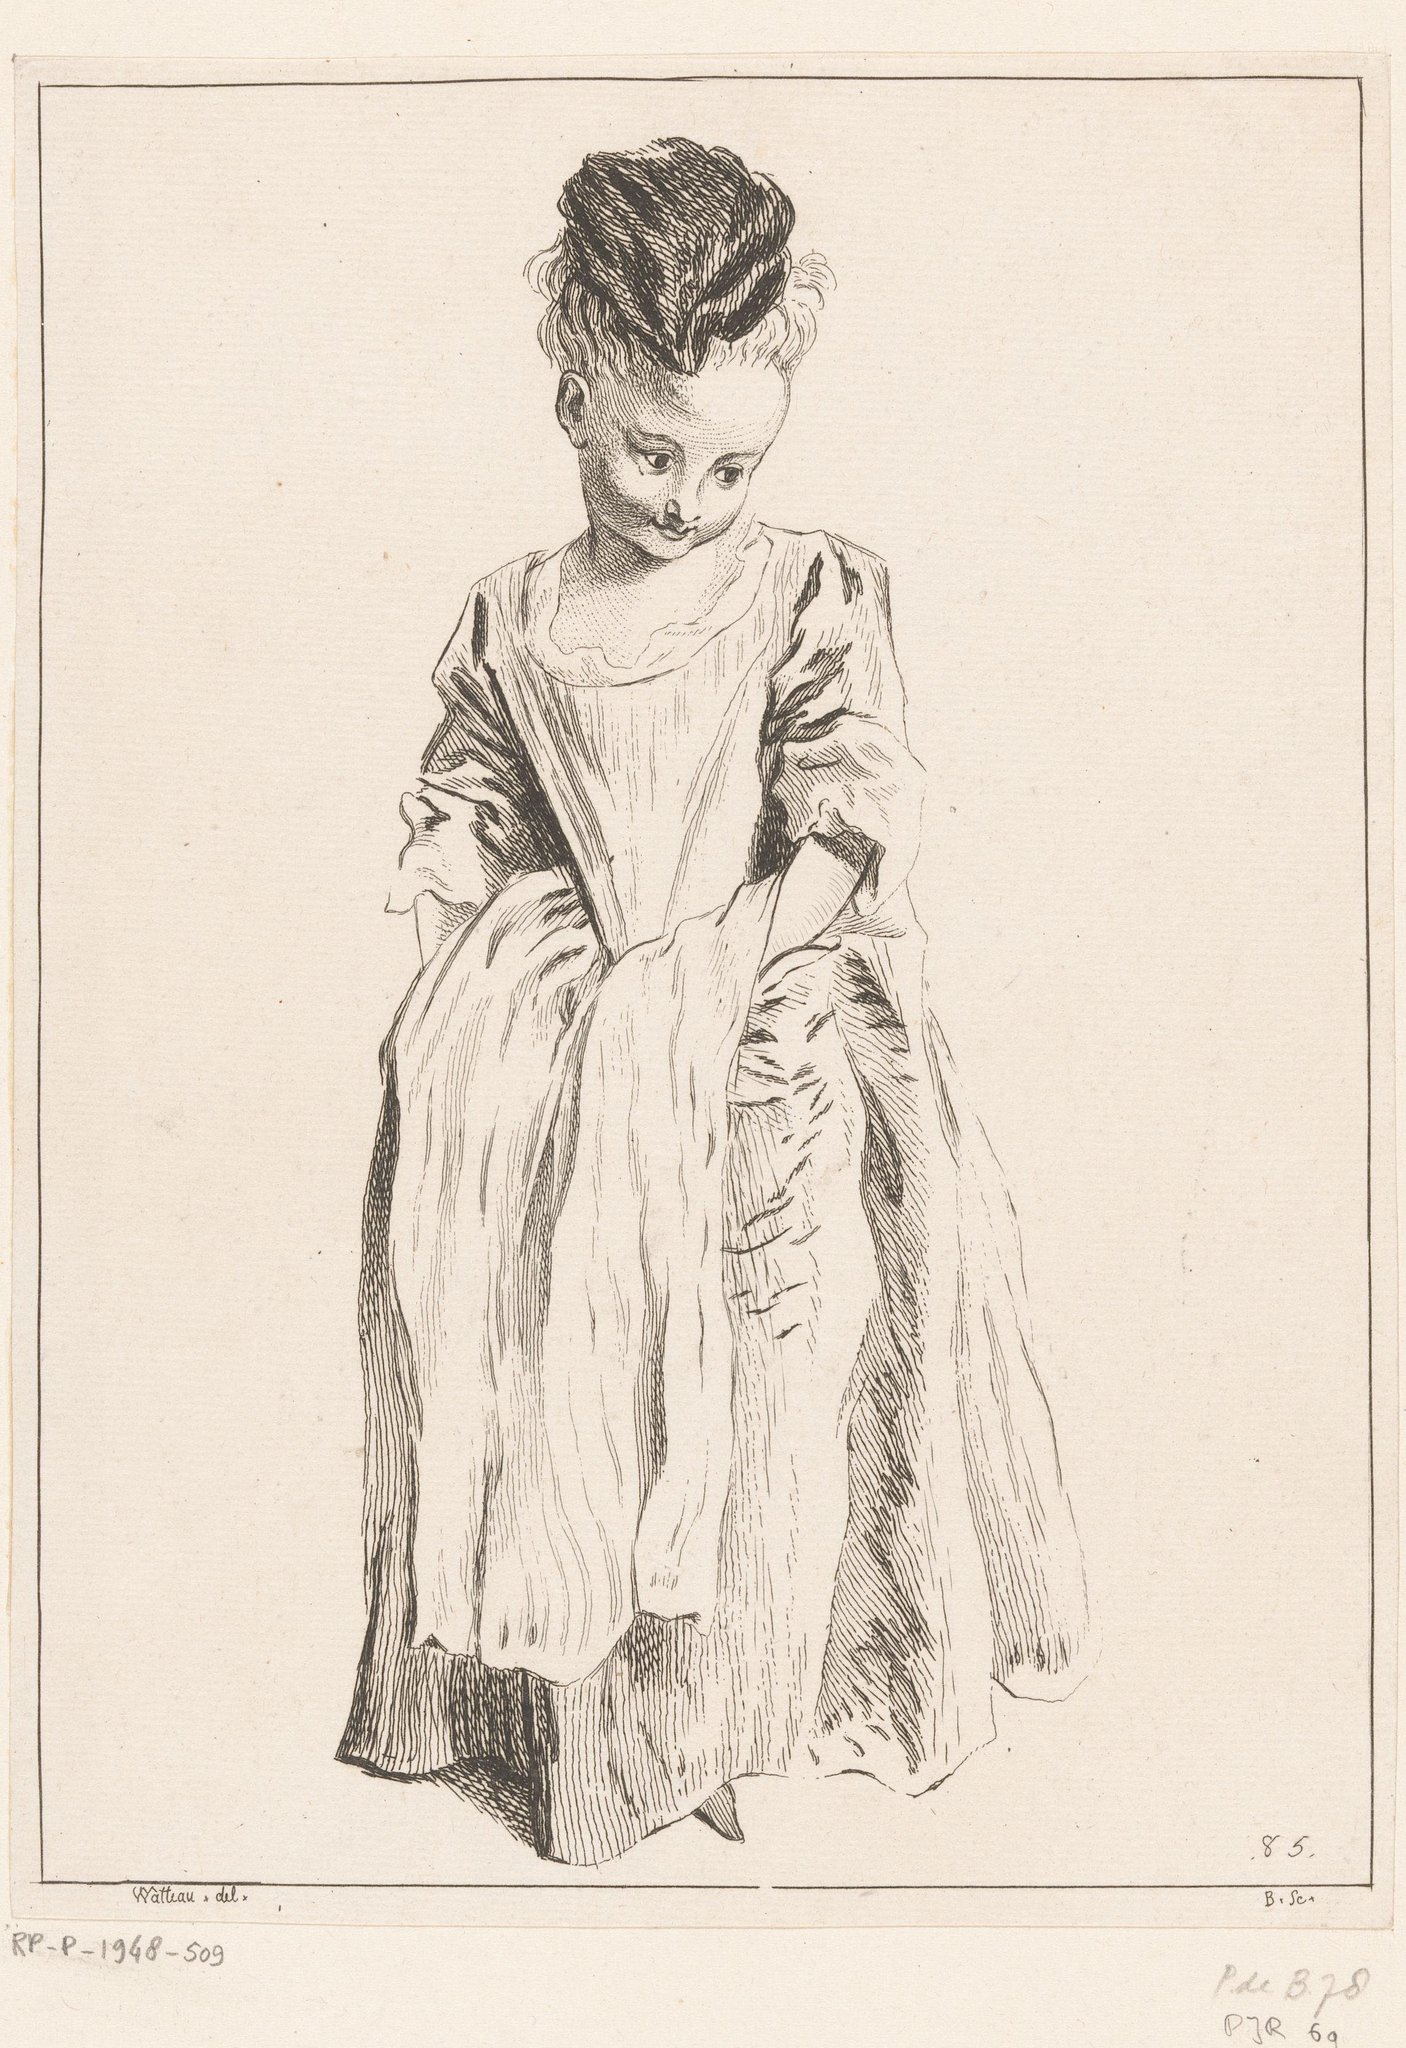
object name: print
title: Figures de différents caractères, de Paysages (...)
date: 1626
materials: paper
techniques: etching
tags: head-gear, girl (child between toddler and youth)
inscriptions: collector's mark: Lugt 2228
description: Maakt deel uit van een serie van 351 prenten, naar tekeningen door Watteau, getiteld 'Figures de différents caractères, de Paysages, et d'Etudes dessinées d'après nature par Antoine Watteau peintre du Roy en son Académie Royale de Peinture et Sculpture Gravées à l'Eau forte par les plus habiles Peintres et Graveurs du temps, tirées des plus beaux cabinets de Paris'. De serie werd geëtst door vijftien verschillende kunstenaars en bestaat uit twee delen. Het eerste deel werd uitgegeven in 1726 en de tweede in 1728.